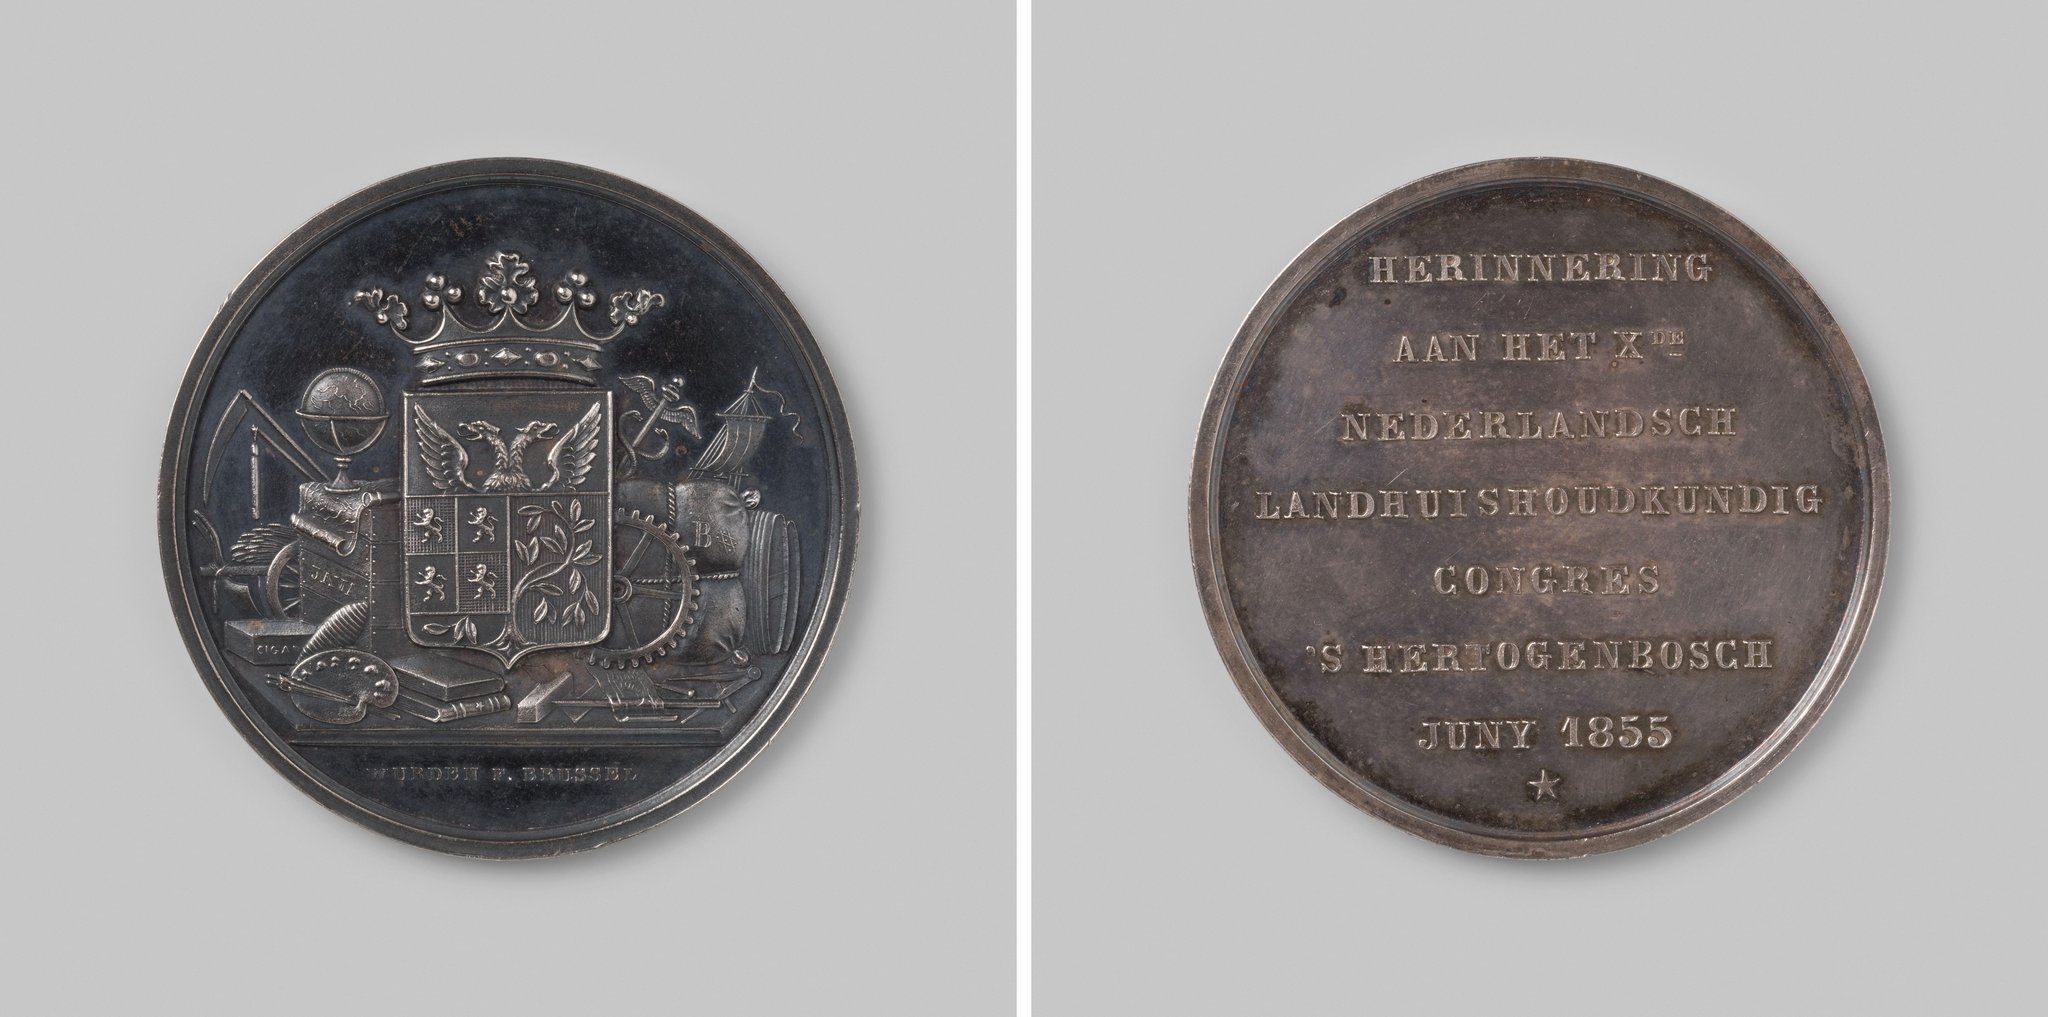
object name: history medal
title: Tiende landhuiskundig congres te 's-Hertogenbosch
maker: jean wurden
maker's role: medailleur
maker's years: 1807-1874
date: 1855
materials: silver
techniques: striking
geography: brussels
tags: den bosch